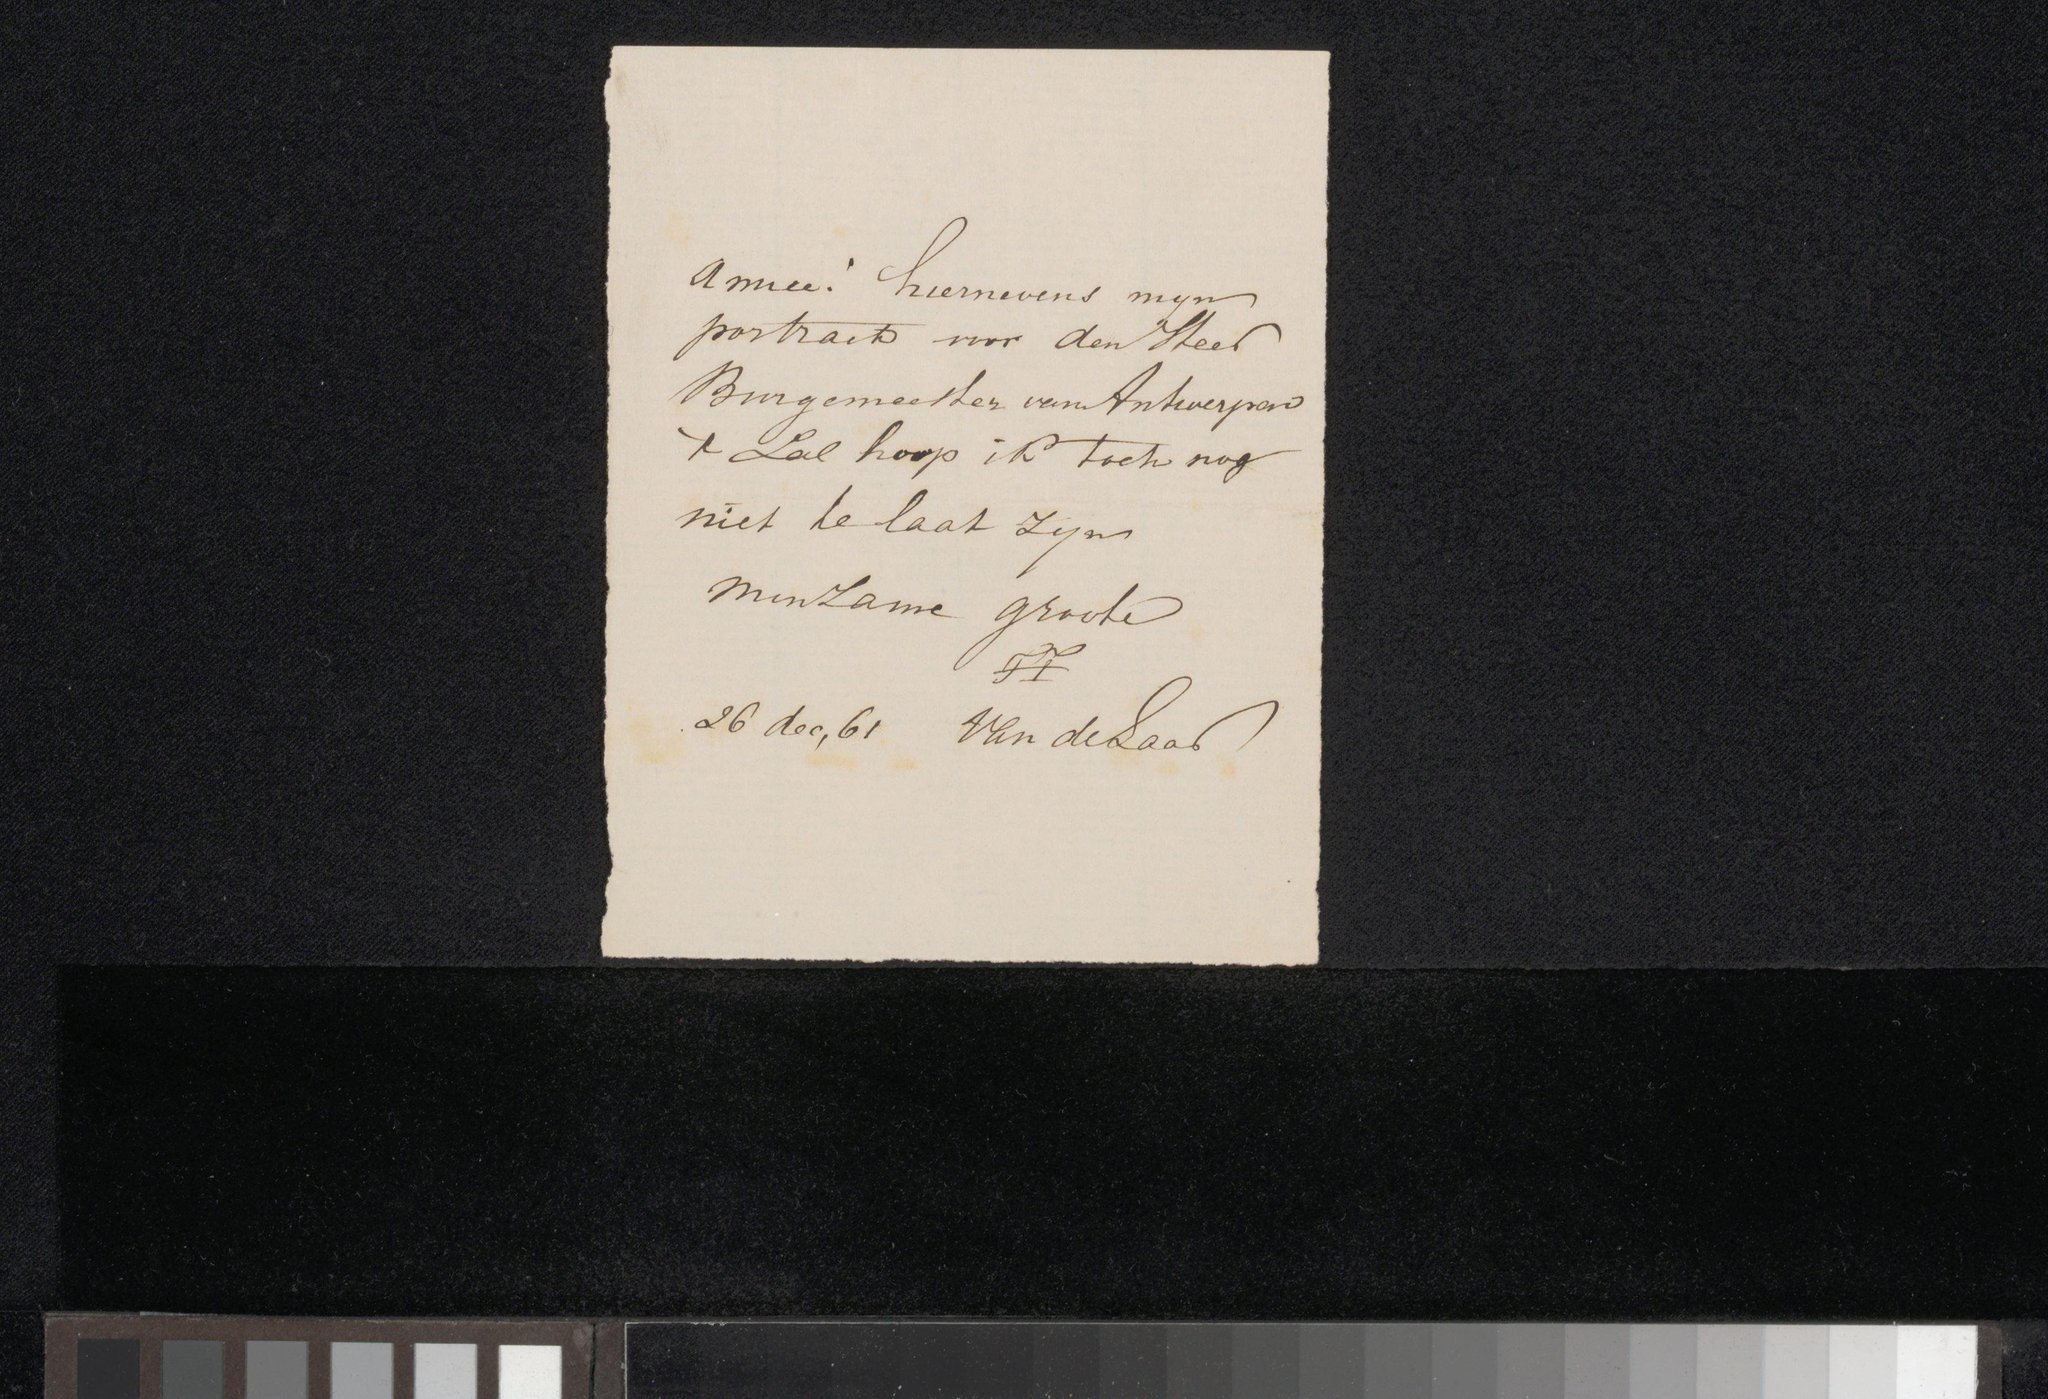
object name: letter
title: Brief aan Ary Johannes Lamme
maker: j.f. van de laar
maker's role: artist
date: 1861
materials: ink, paper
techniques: pen, writing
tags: antwerp, dordrecht, print maker, draughtsman, ary johannes lamme, historical persons (portraits and scenes from the life)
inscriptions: collector's mark: Lugt 2228